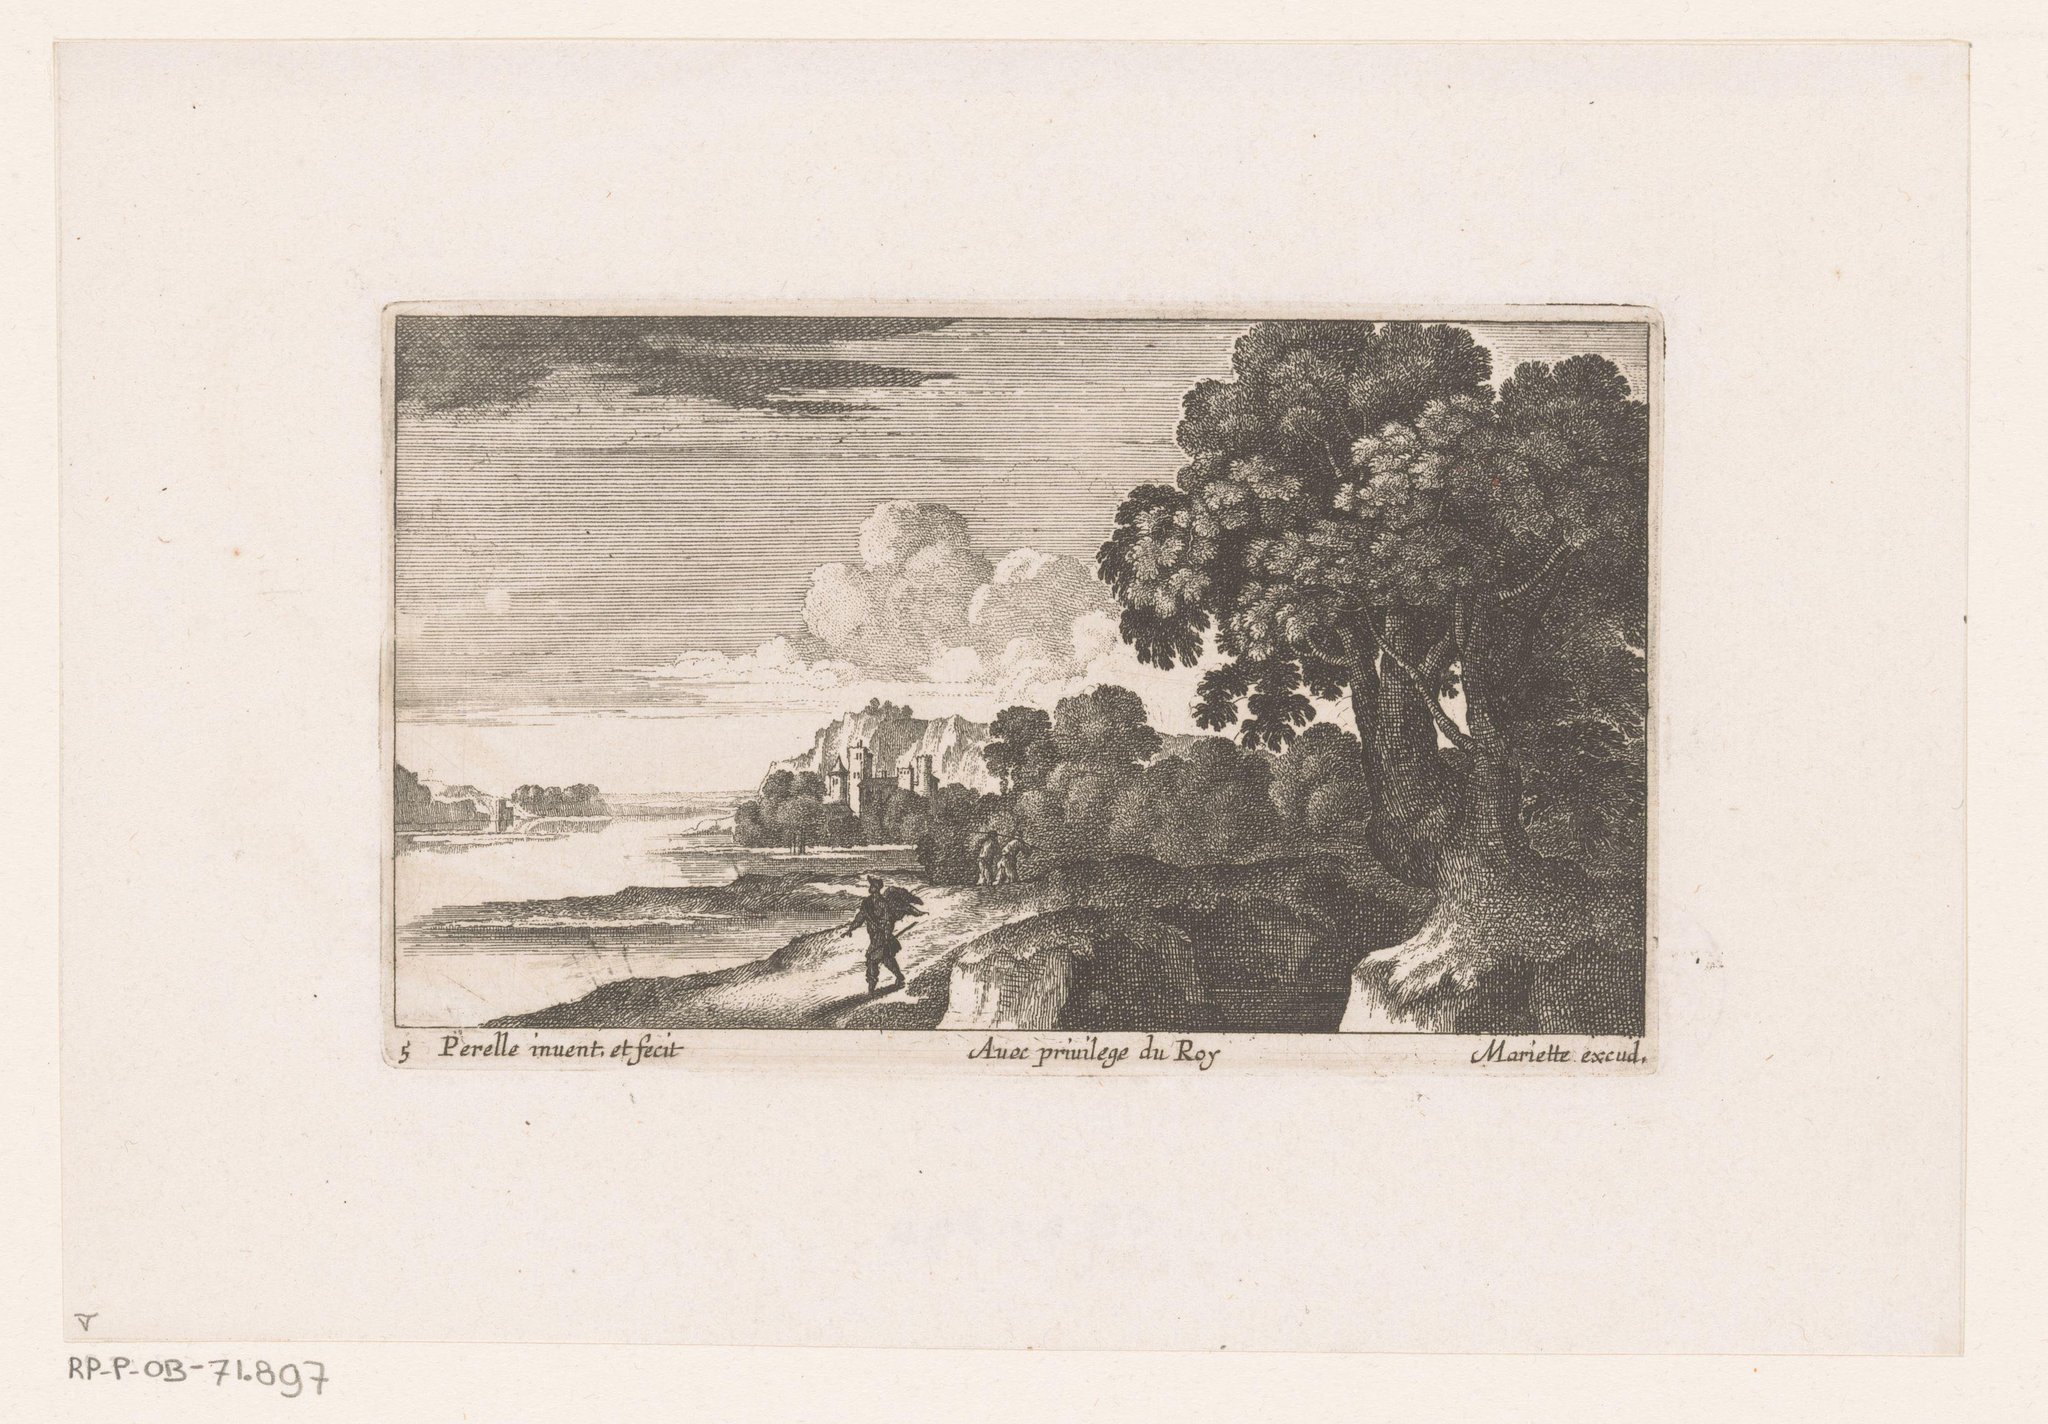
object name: print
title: Rivierlandschappen met gebouwen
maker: mariette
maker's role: publisher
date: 1613-1695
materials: paper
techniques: etching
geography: france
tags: landscapes with waters, waterscapes, seascapes (in the temperate zone)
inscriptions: collector's mark: Lugt 240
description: Prenten met het signatuur 'Perelle' kunnen zowel door vader Gabriel als door zonen Nicolas en Adam gemaakt zijn.